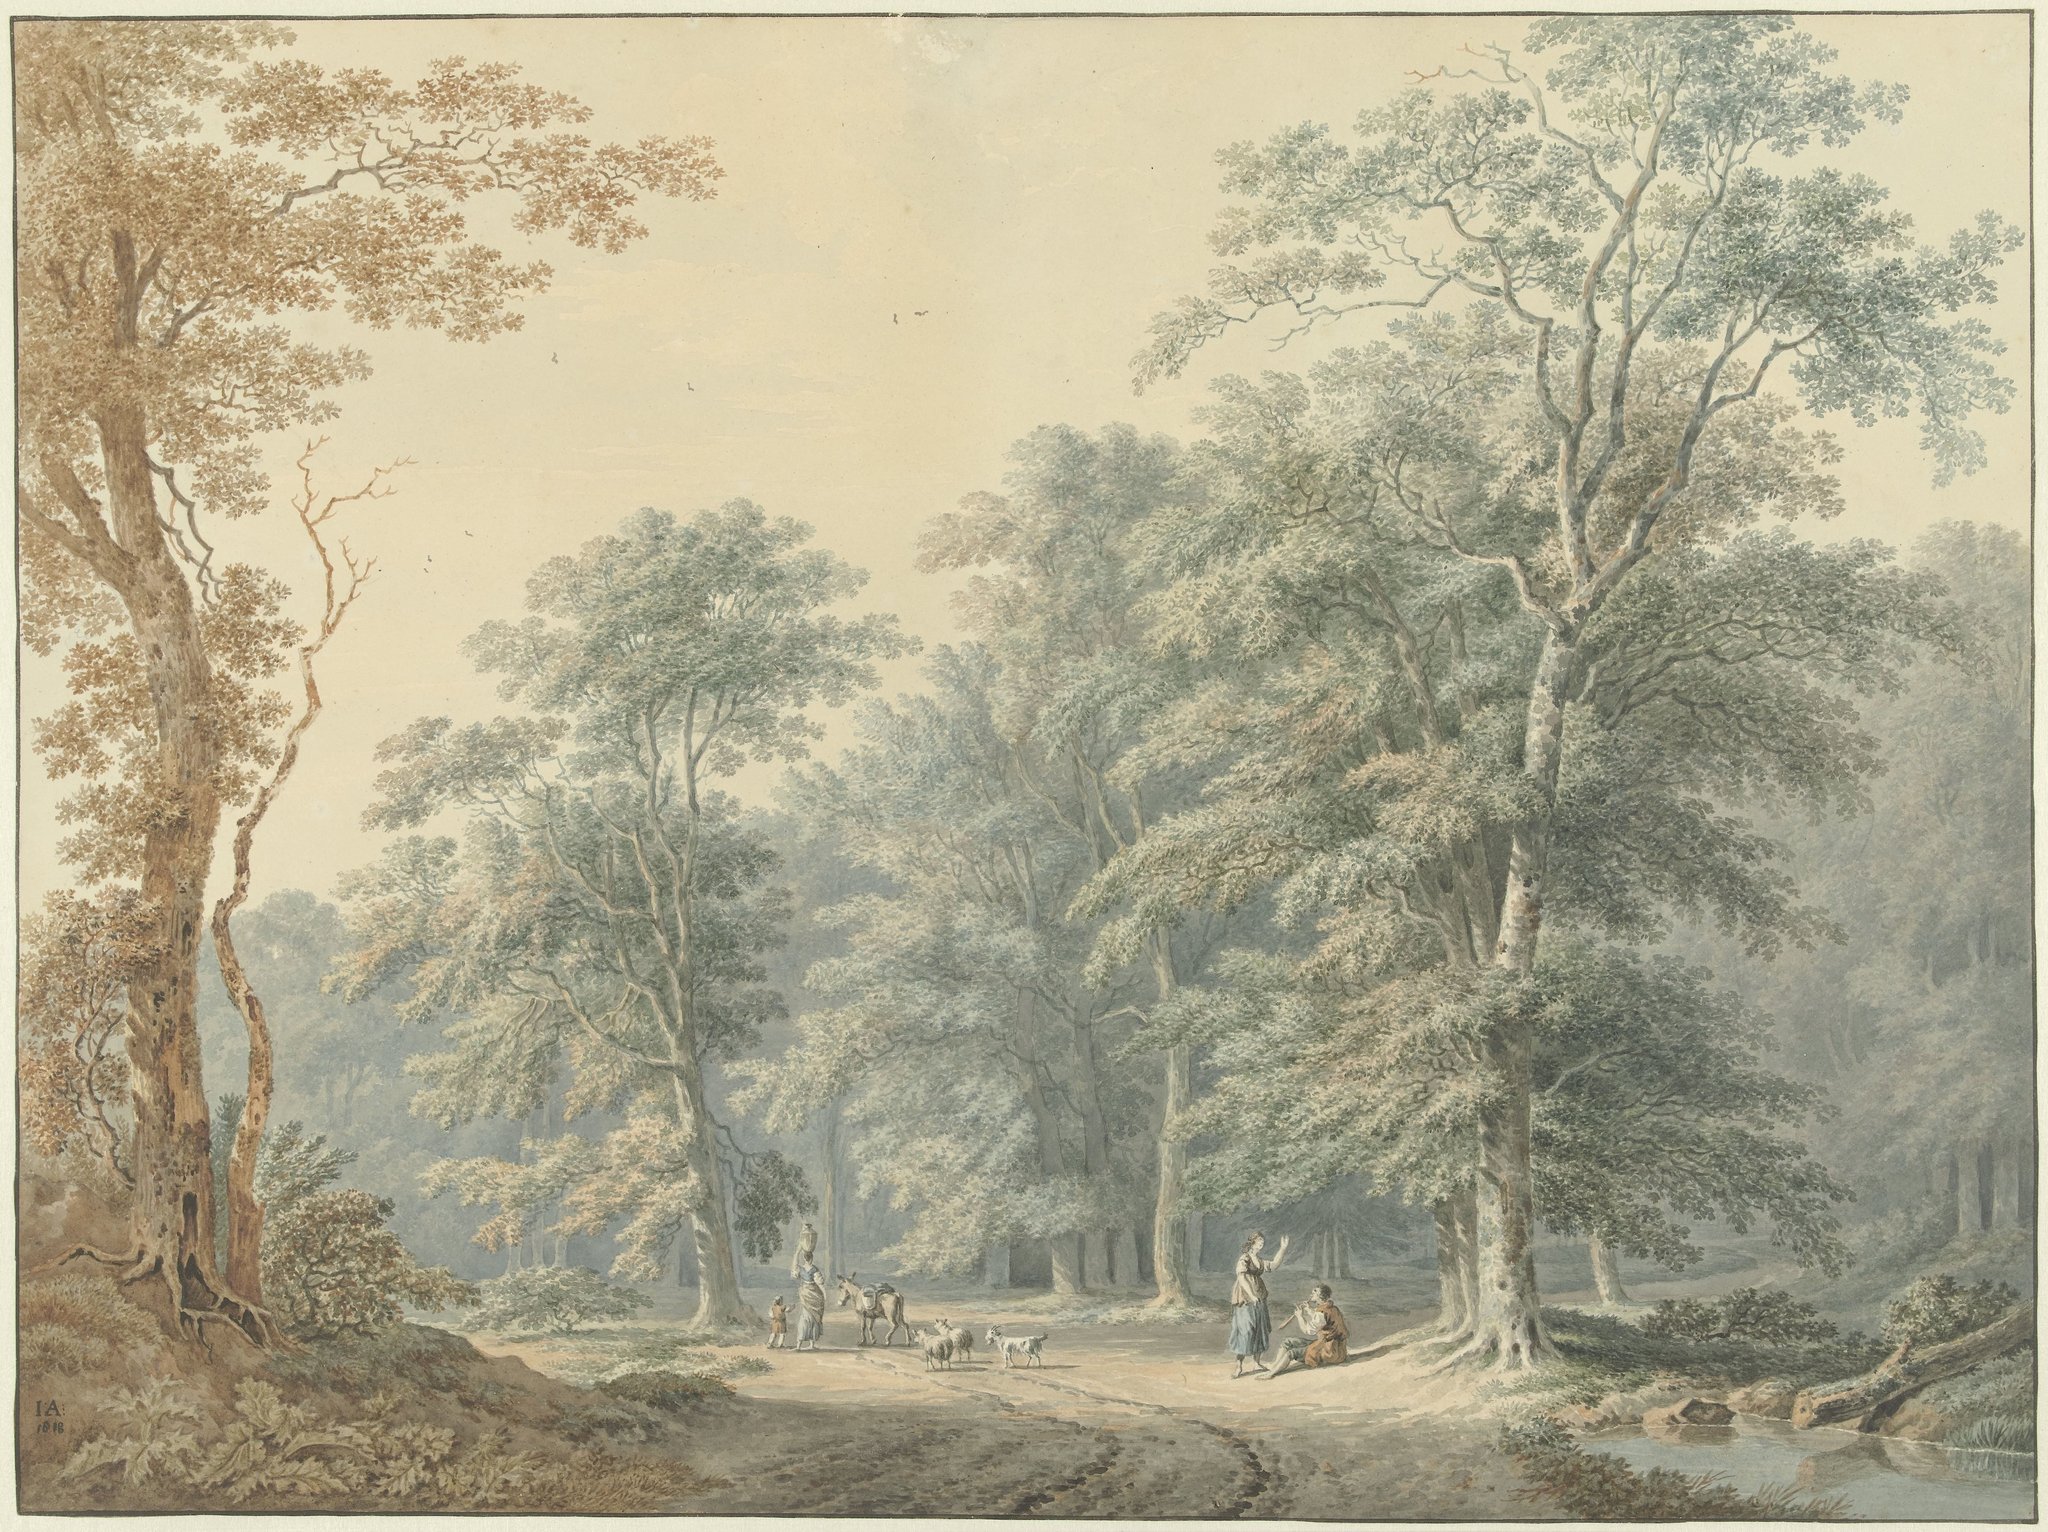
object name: drawing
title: Bosgezicht met klassicistische stoffage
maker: jan apeldoorn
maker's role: draughtsman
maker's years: 1765-1838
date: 1818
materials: paper, pencil, watercolor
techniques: brush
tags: forest, wood